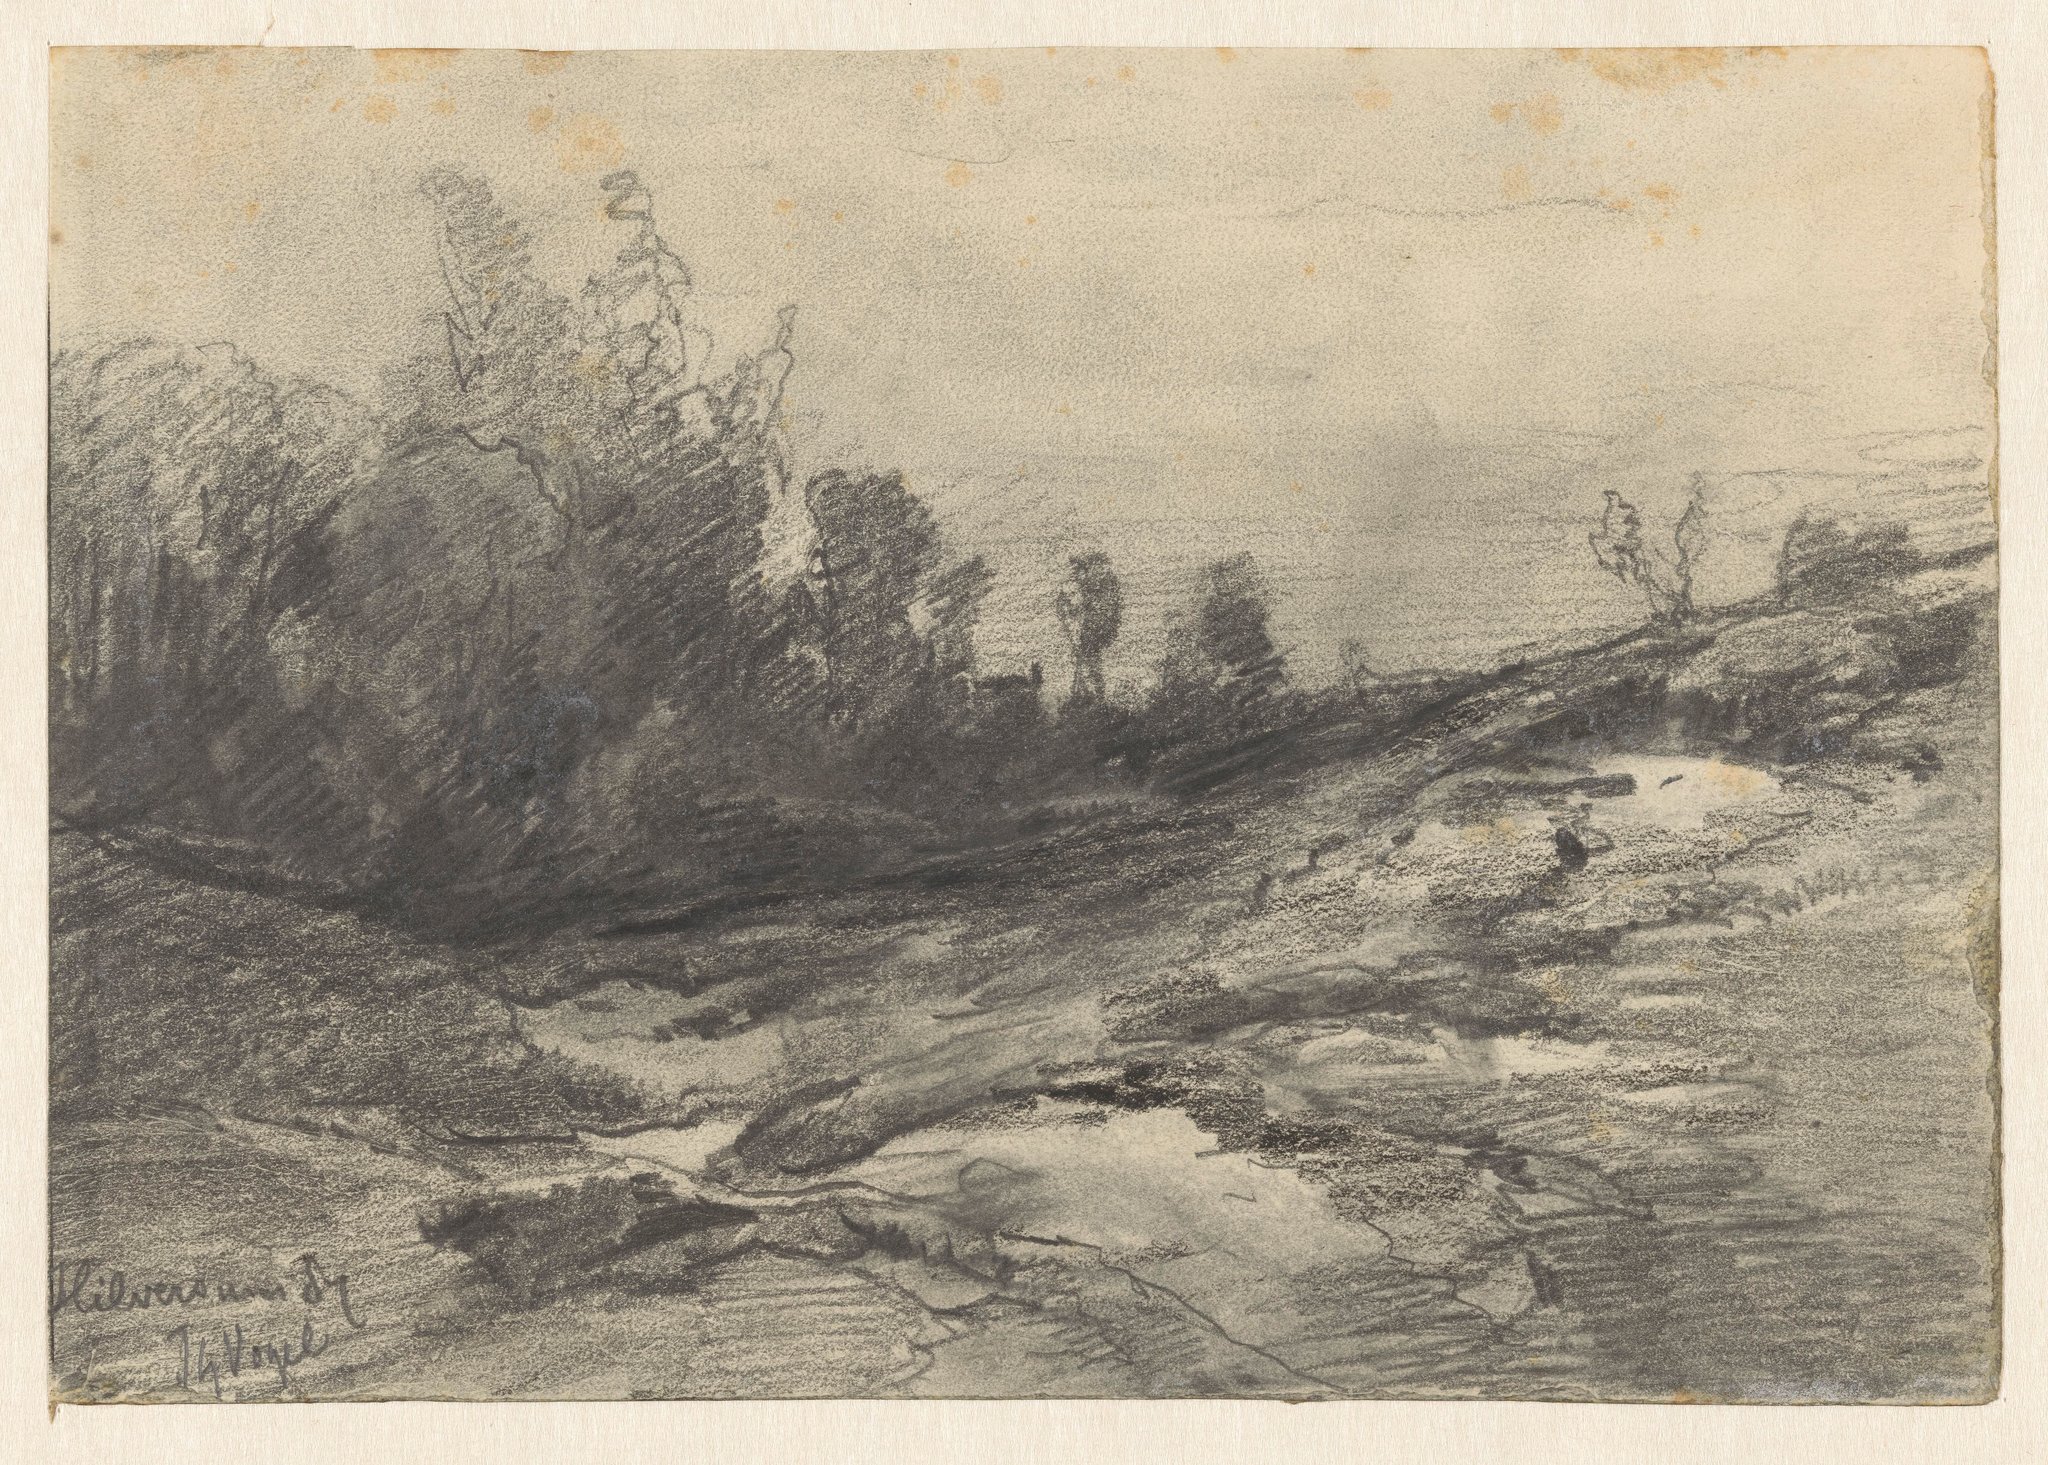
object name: drawing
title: Landschap bij Hilversum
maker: johannes gijsbert vogel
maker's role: draughtsman, painter, print maker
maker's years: 1828-1915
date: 1887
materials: chalk, paper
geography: hilversum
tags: plain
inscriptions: date